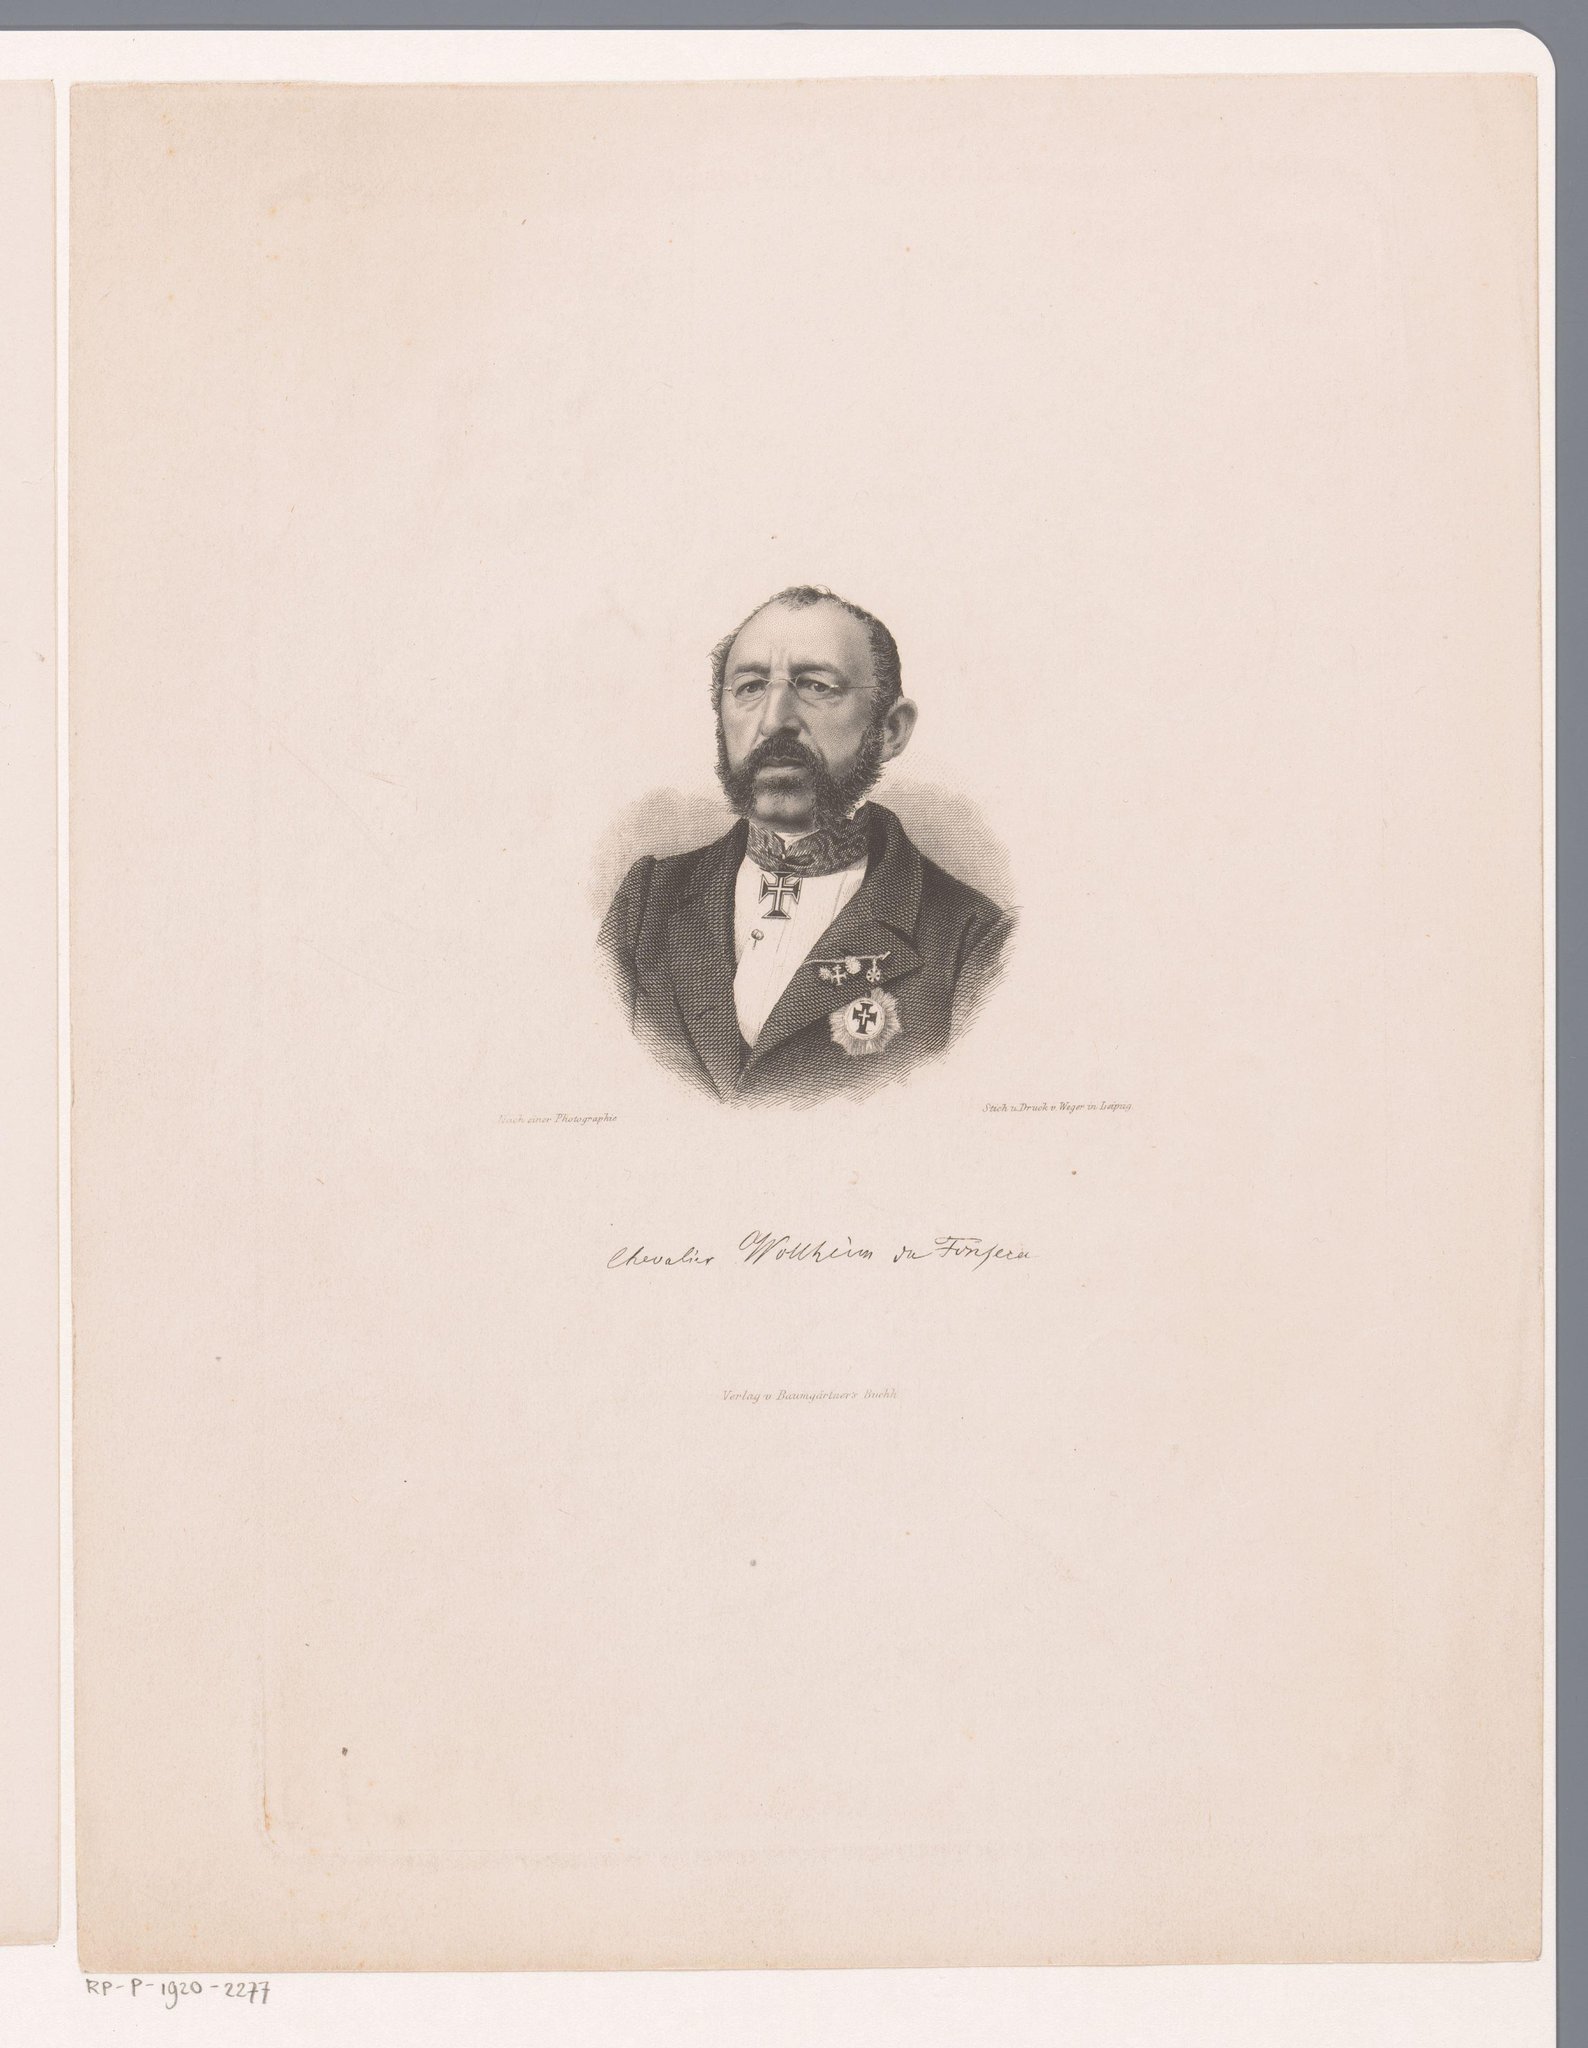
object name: print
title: Portret van Anton Eduard Wollheim da Fonseca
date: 1860-1892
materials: paper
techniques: engraving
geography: leipzig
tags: berlin, historical persons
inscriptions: collector's mark: Lugt 2228